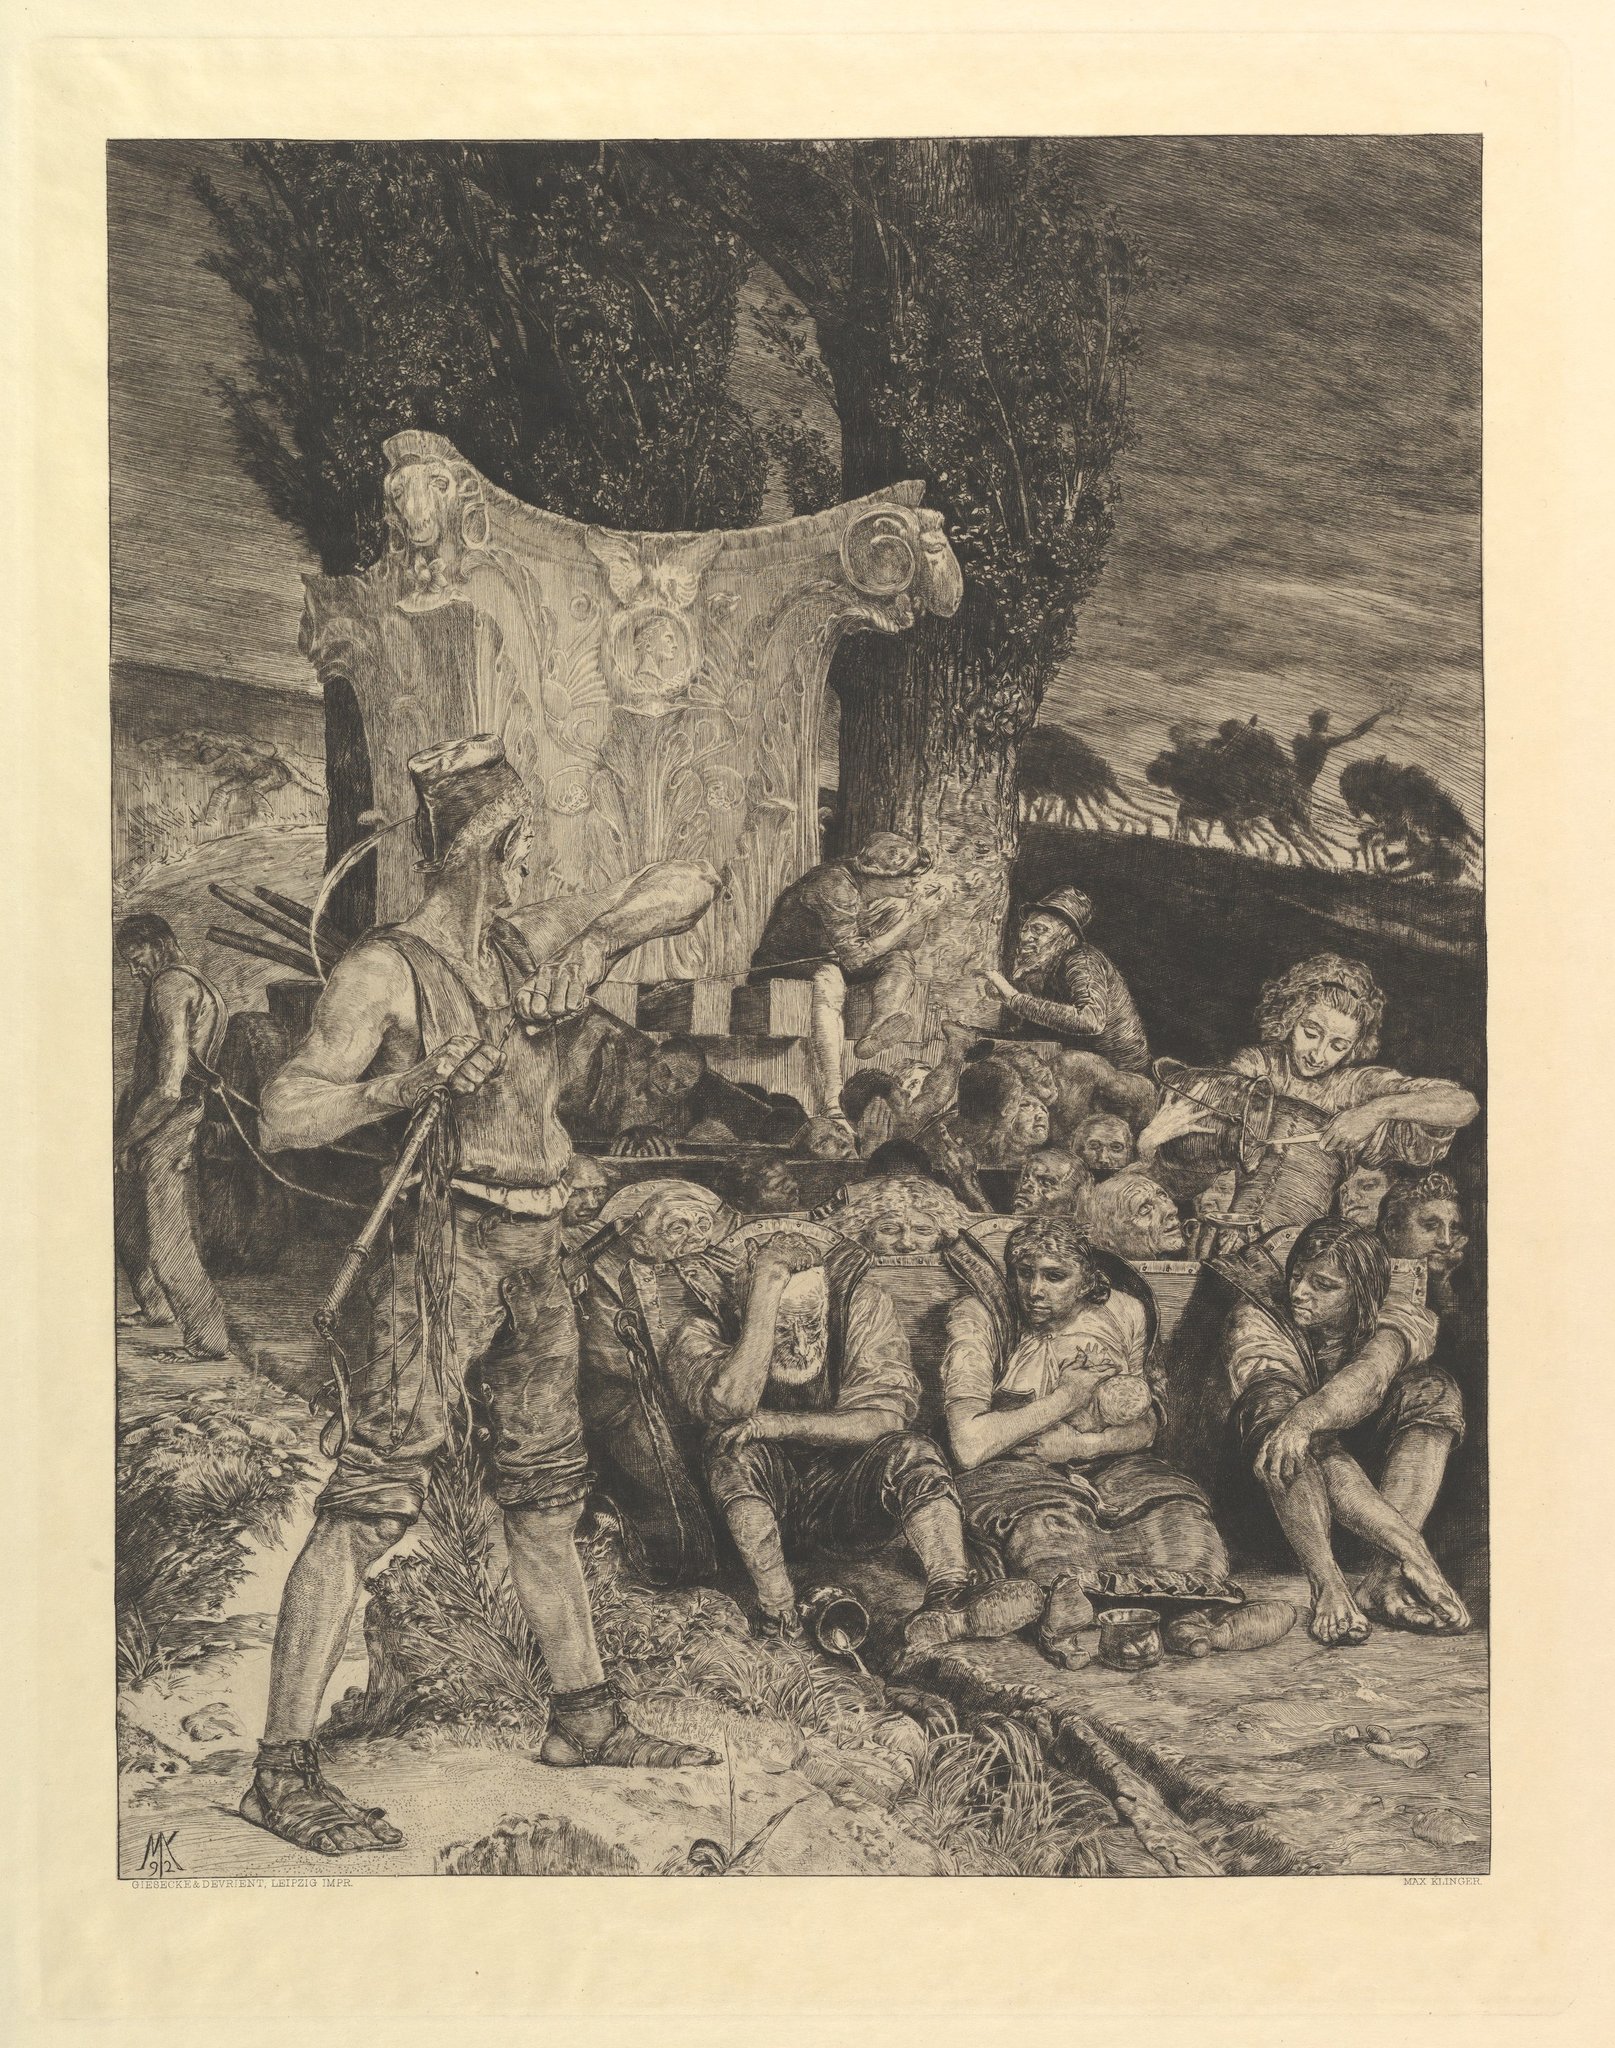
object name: print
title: Elend, from the series Vom Tode Zweiter Teil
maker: max klinger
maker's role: artist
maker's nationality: german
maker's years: 1857-1920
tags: men,women